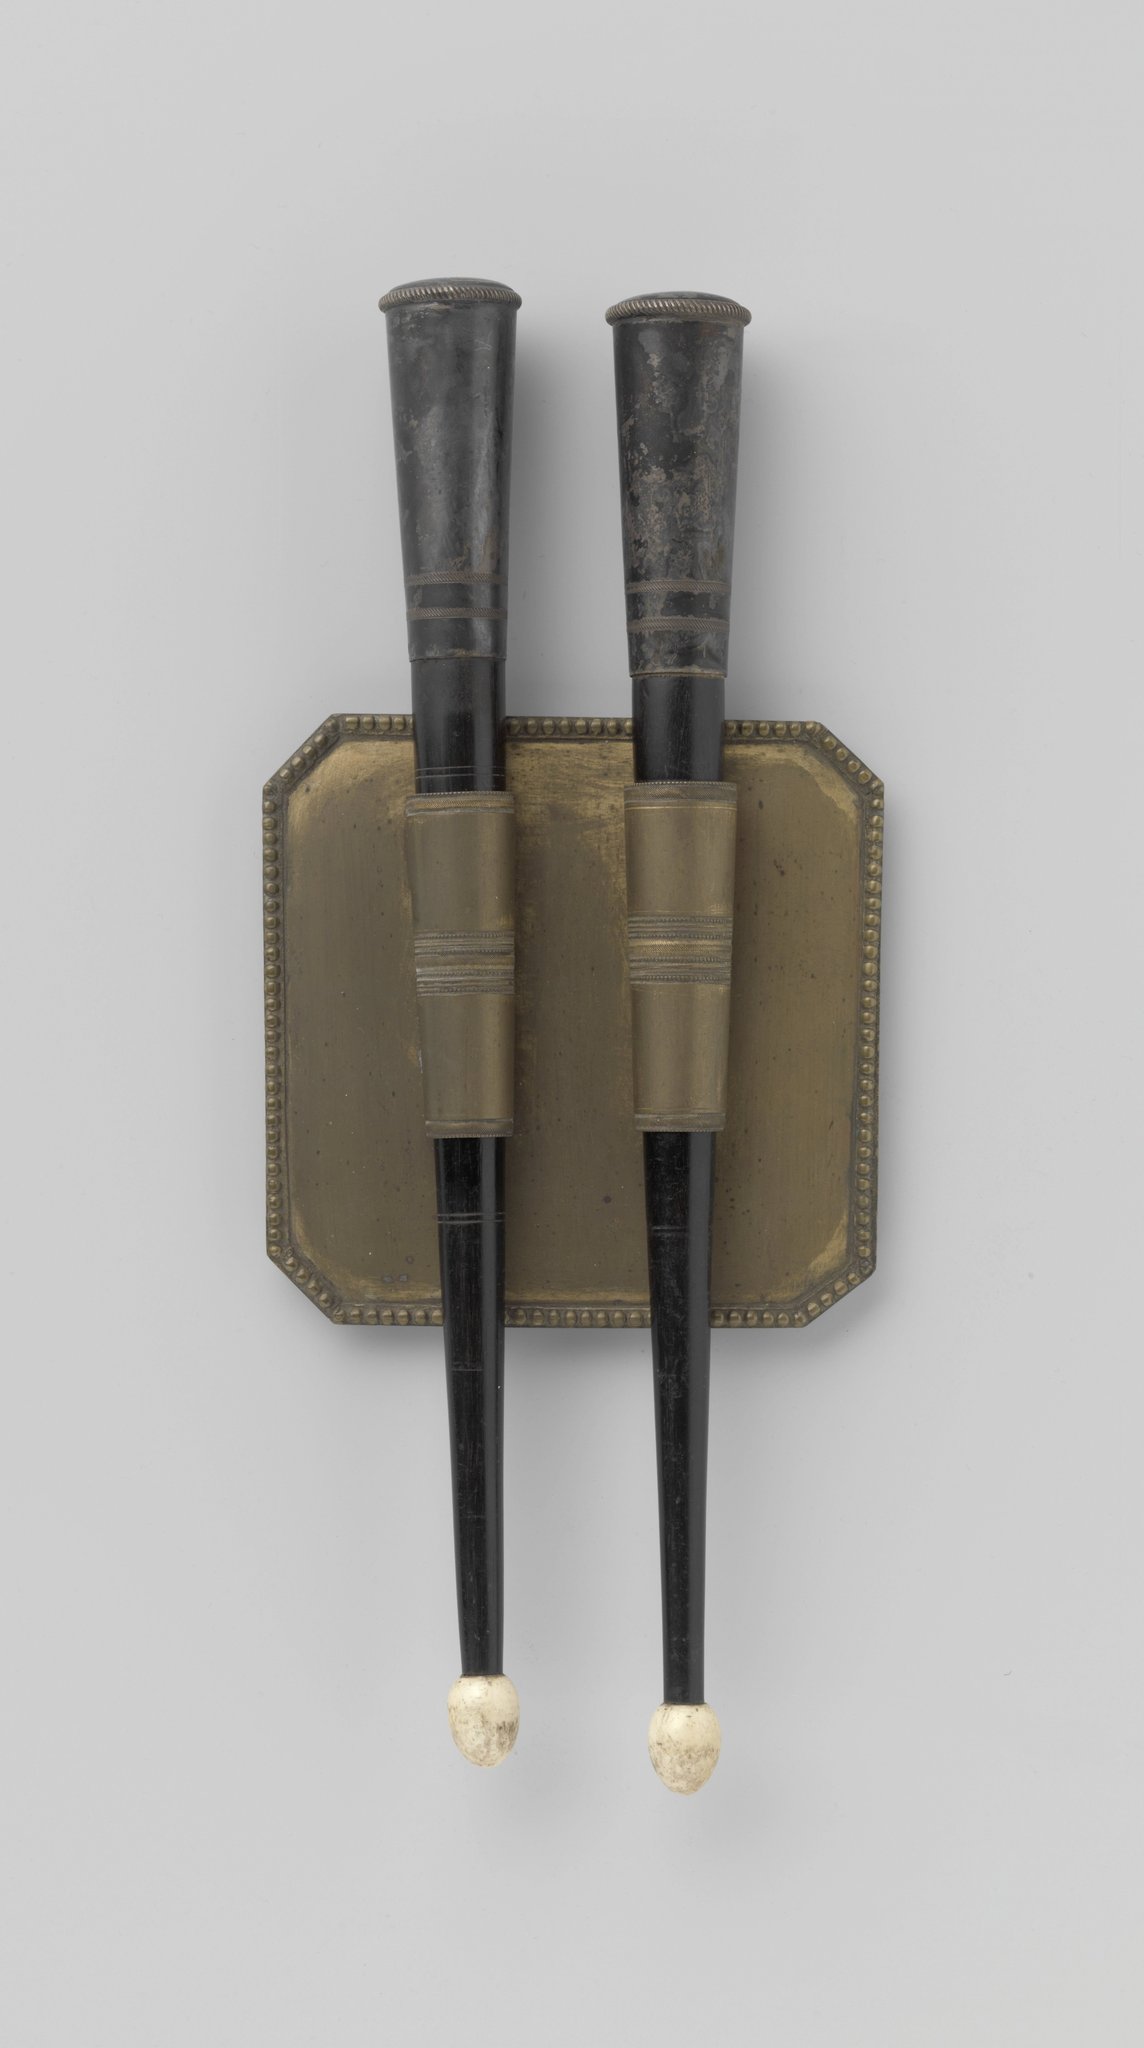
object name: percussion instrument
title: Drumsticks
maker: Anonymous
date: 1823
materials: copper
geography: netherlands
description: Stokplaat van messing en trommelstokken voor tamboer-majoor.